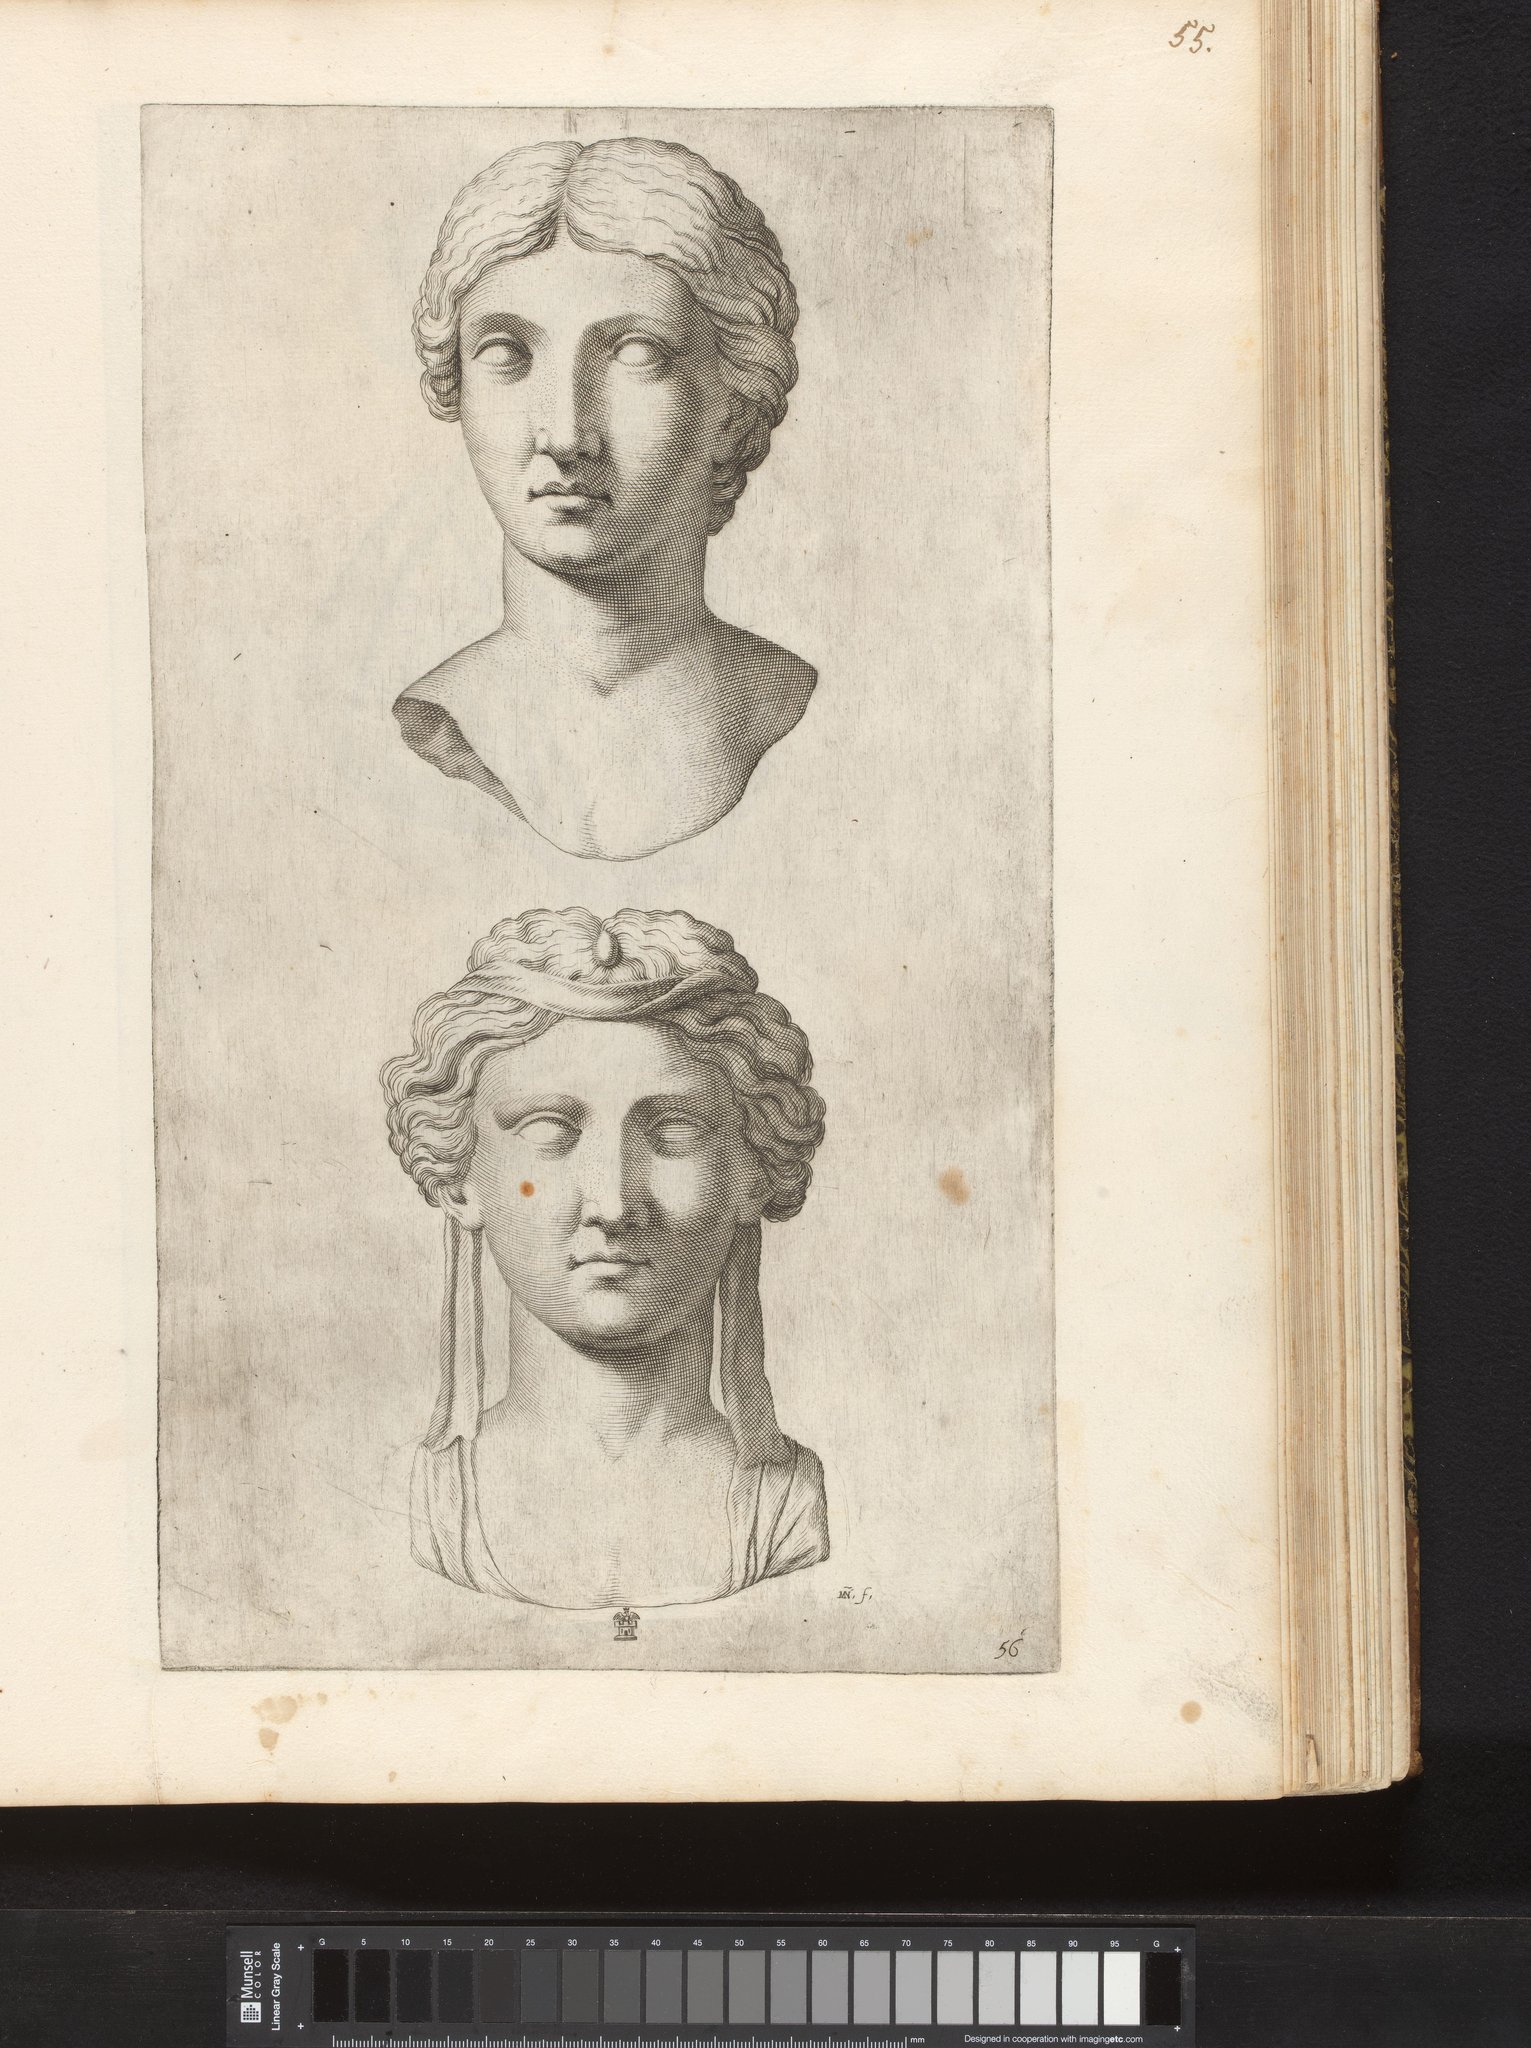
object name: print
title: Galleria Giustiniana del Marchese Vincenzo Giustiniani II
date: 1636-1647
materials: paper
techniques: engraving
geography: rome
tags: piece of sculpture, reproduction of a piece of sculpture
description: Twee Romeinse portretbustes van Giulia Domna en Giulia Mamea. Op de basis van de onderste buste het wapenschild van Vincenzo Giustiniani. Prent maakt deel uit van een album met een serie prenten naar de sculpturen in de verzameling in de Galleria Giustiniani te Rome.